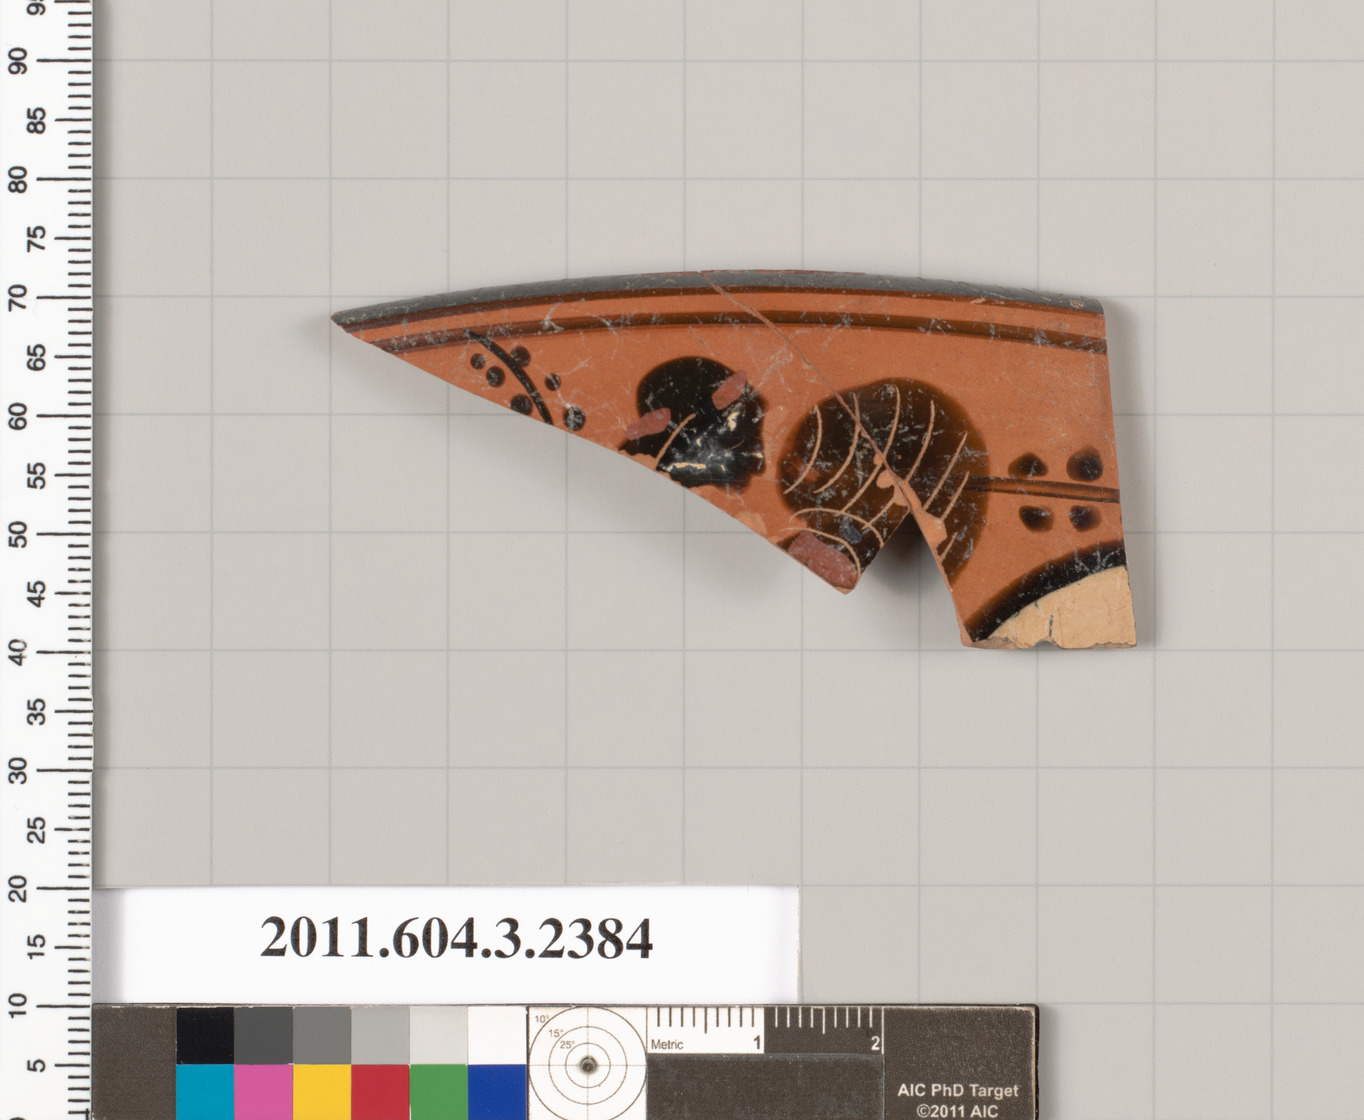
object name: kylix fragment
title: Terracotta rim fragment of a kylix: eye-cup (drinking cup)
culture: greek, attic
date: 530-500 BCE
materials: terracotta